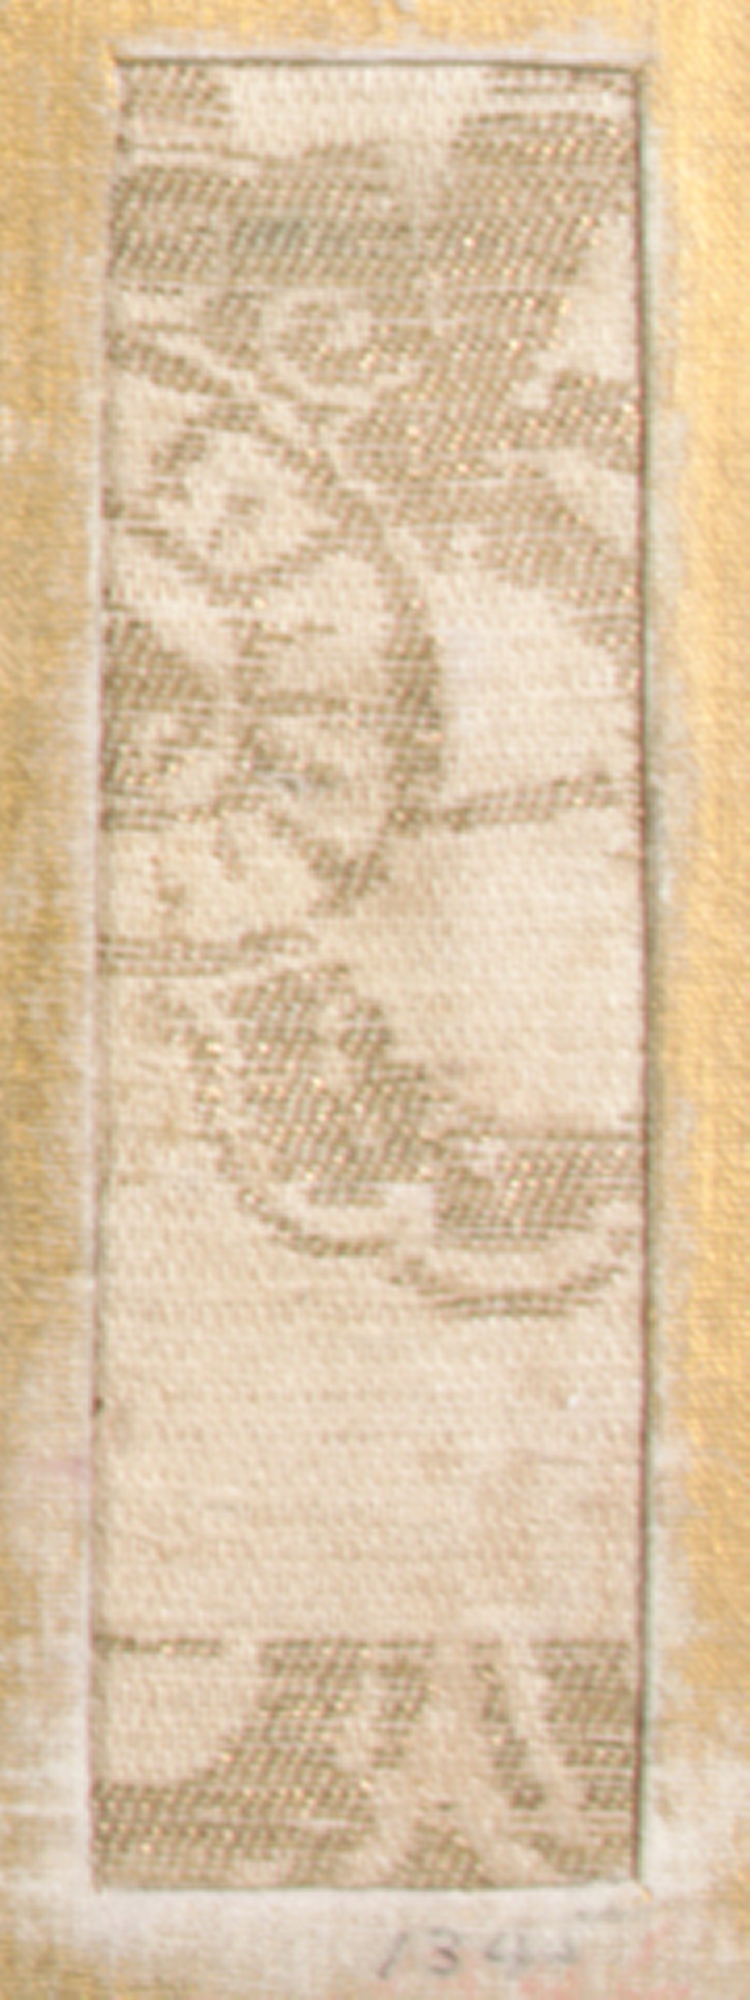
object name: piece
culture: japanese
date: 1701-1900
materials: silk